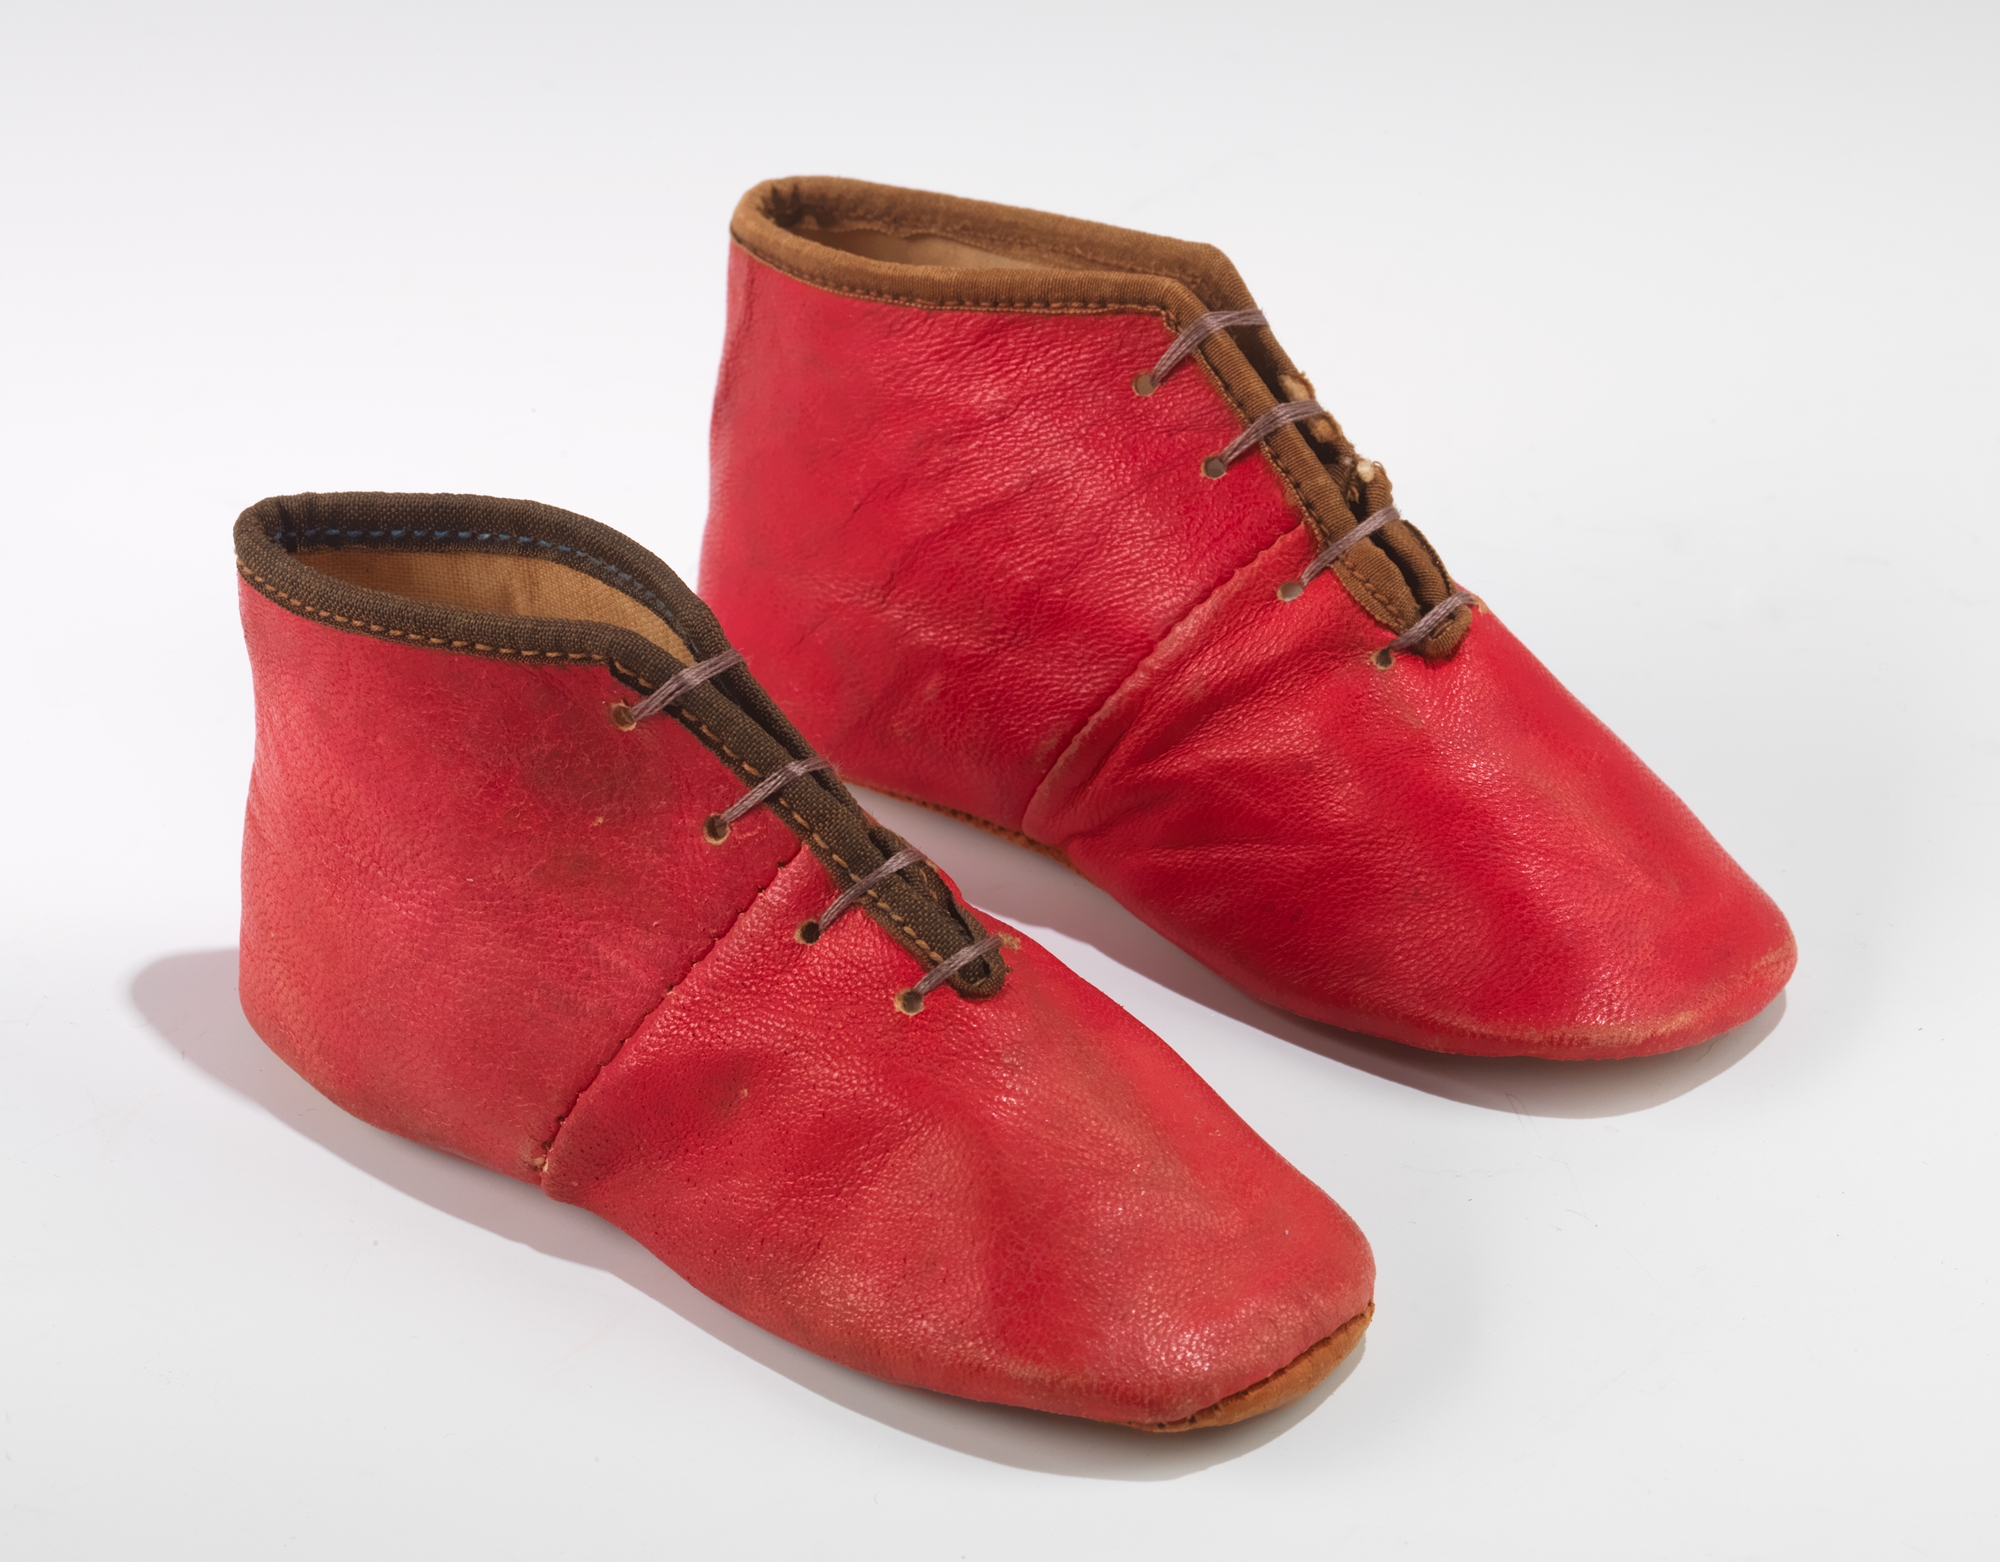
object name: shoe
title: Shoes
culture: american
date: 1840-1849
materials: leather